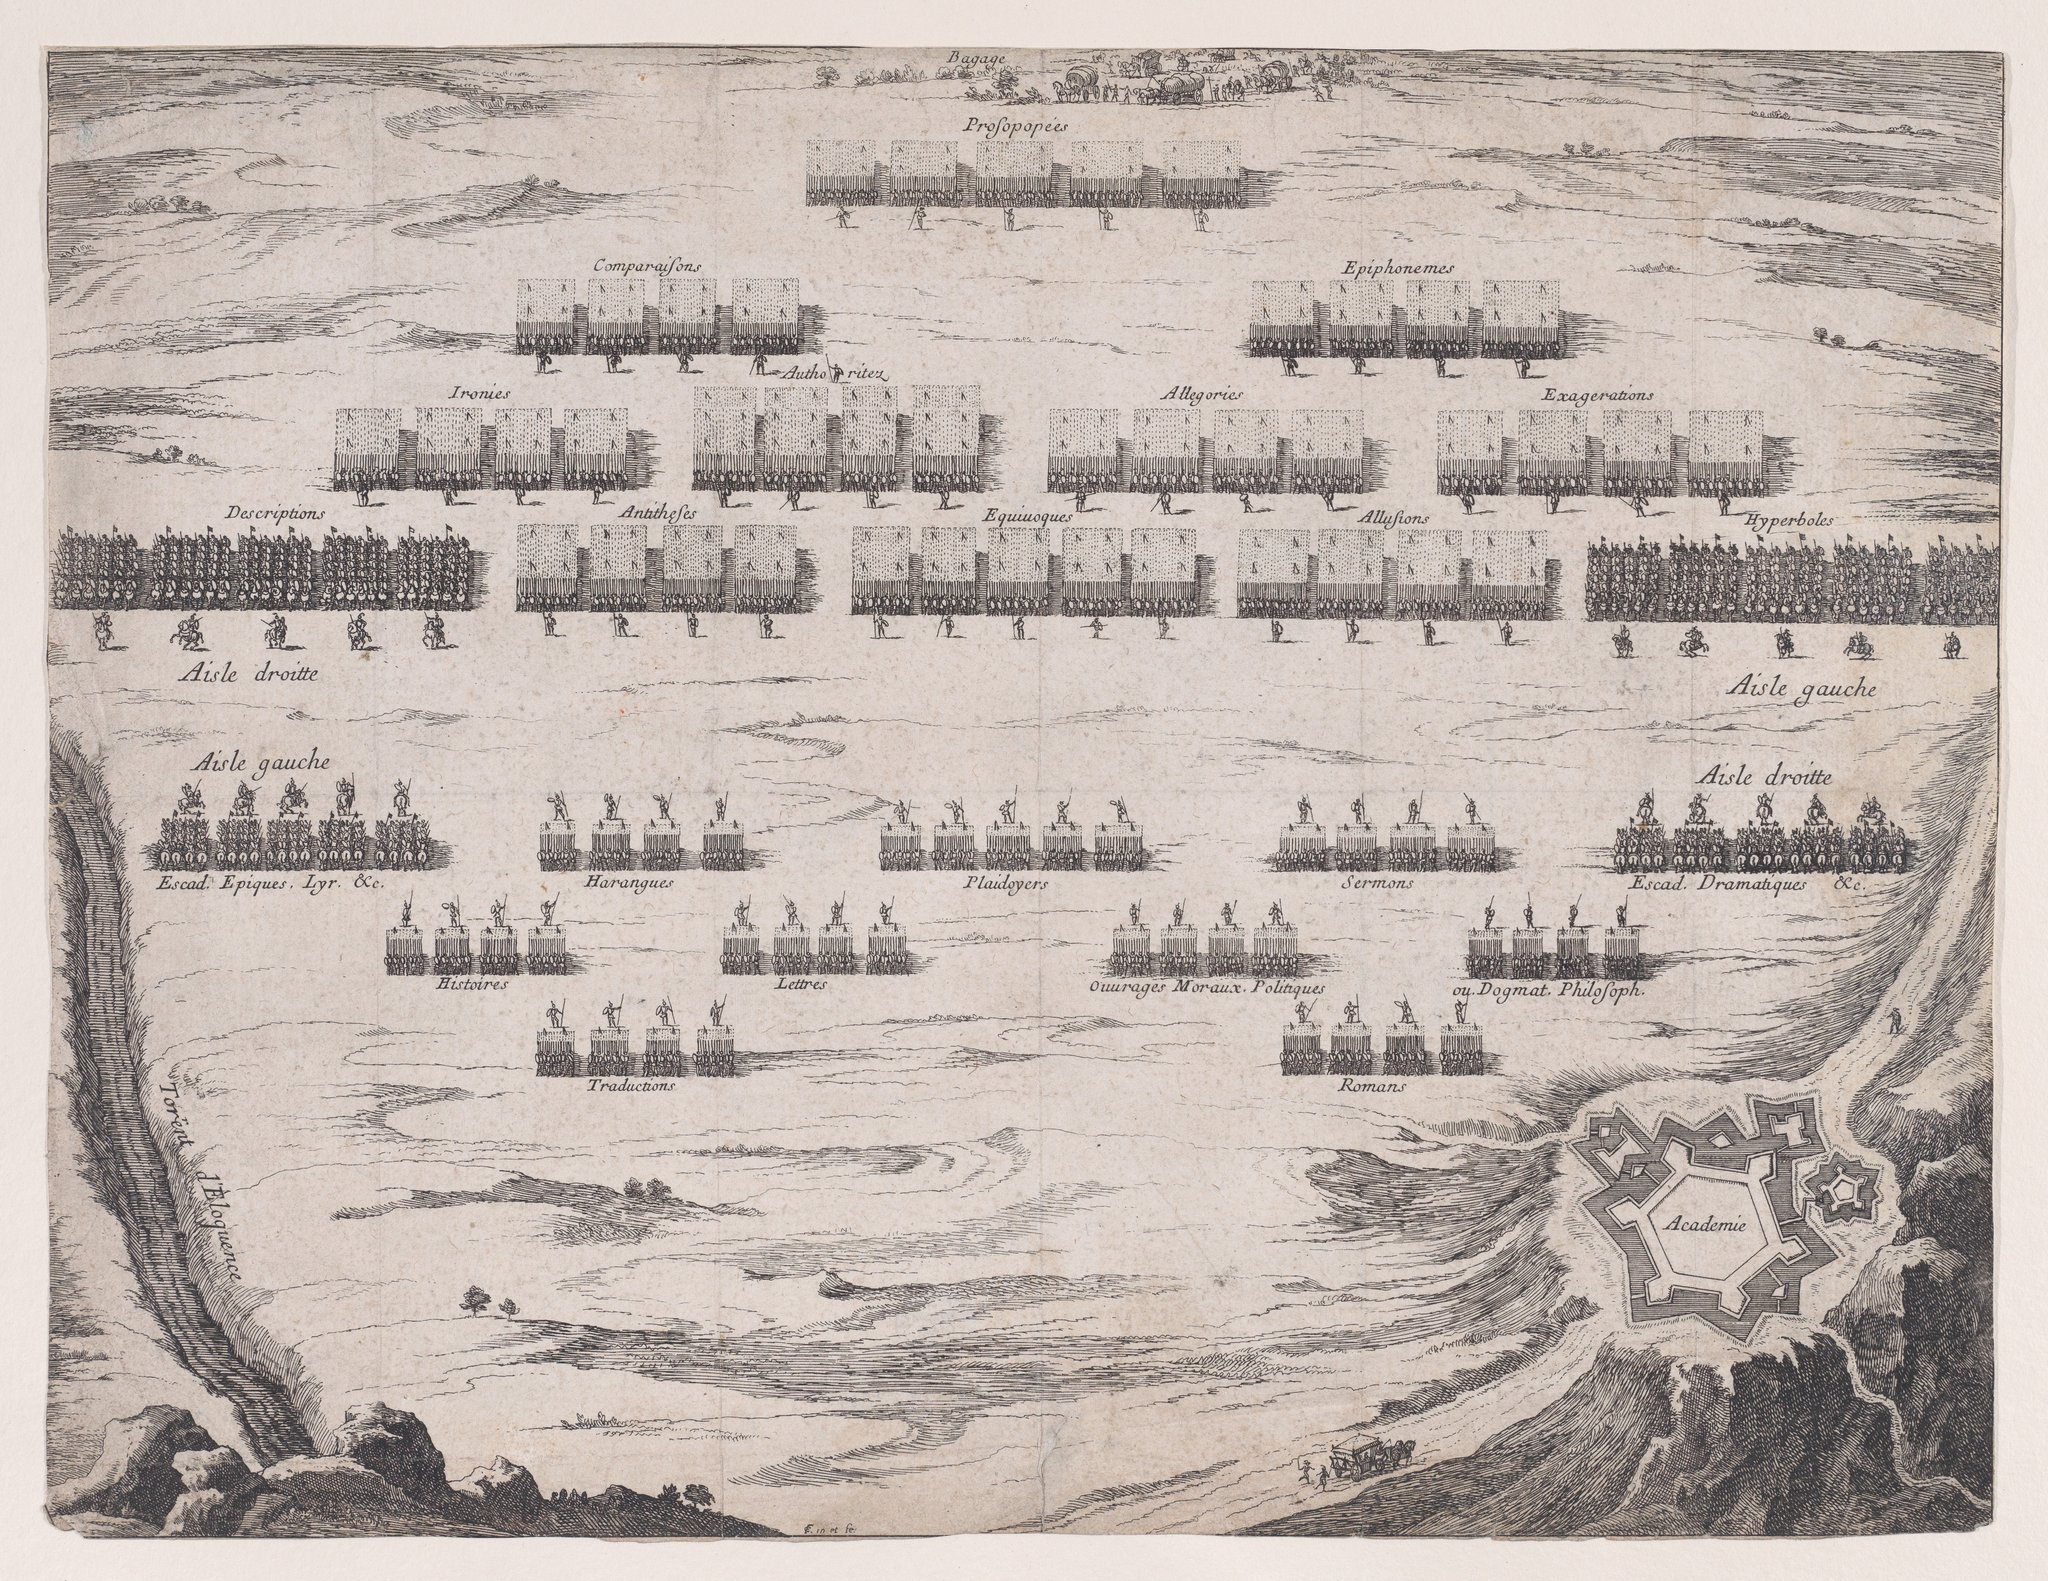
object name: print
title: Combat de la Louange et de la Satire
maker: françois chauveau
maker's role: artist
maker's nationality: french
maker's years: 1613-1676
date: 1601-1700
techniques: etching